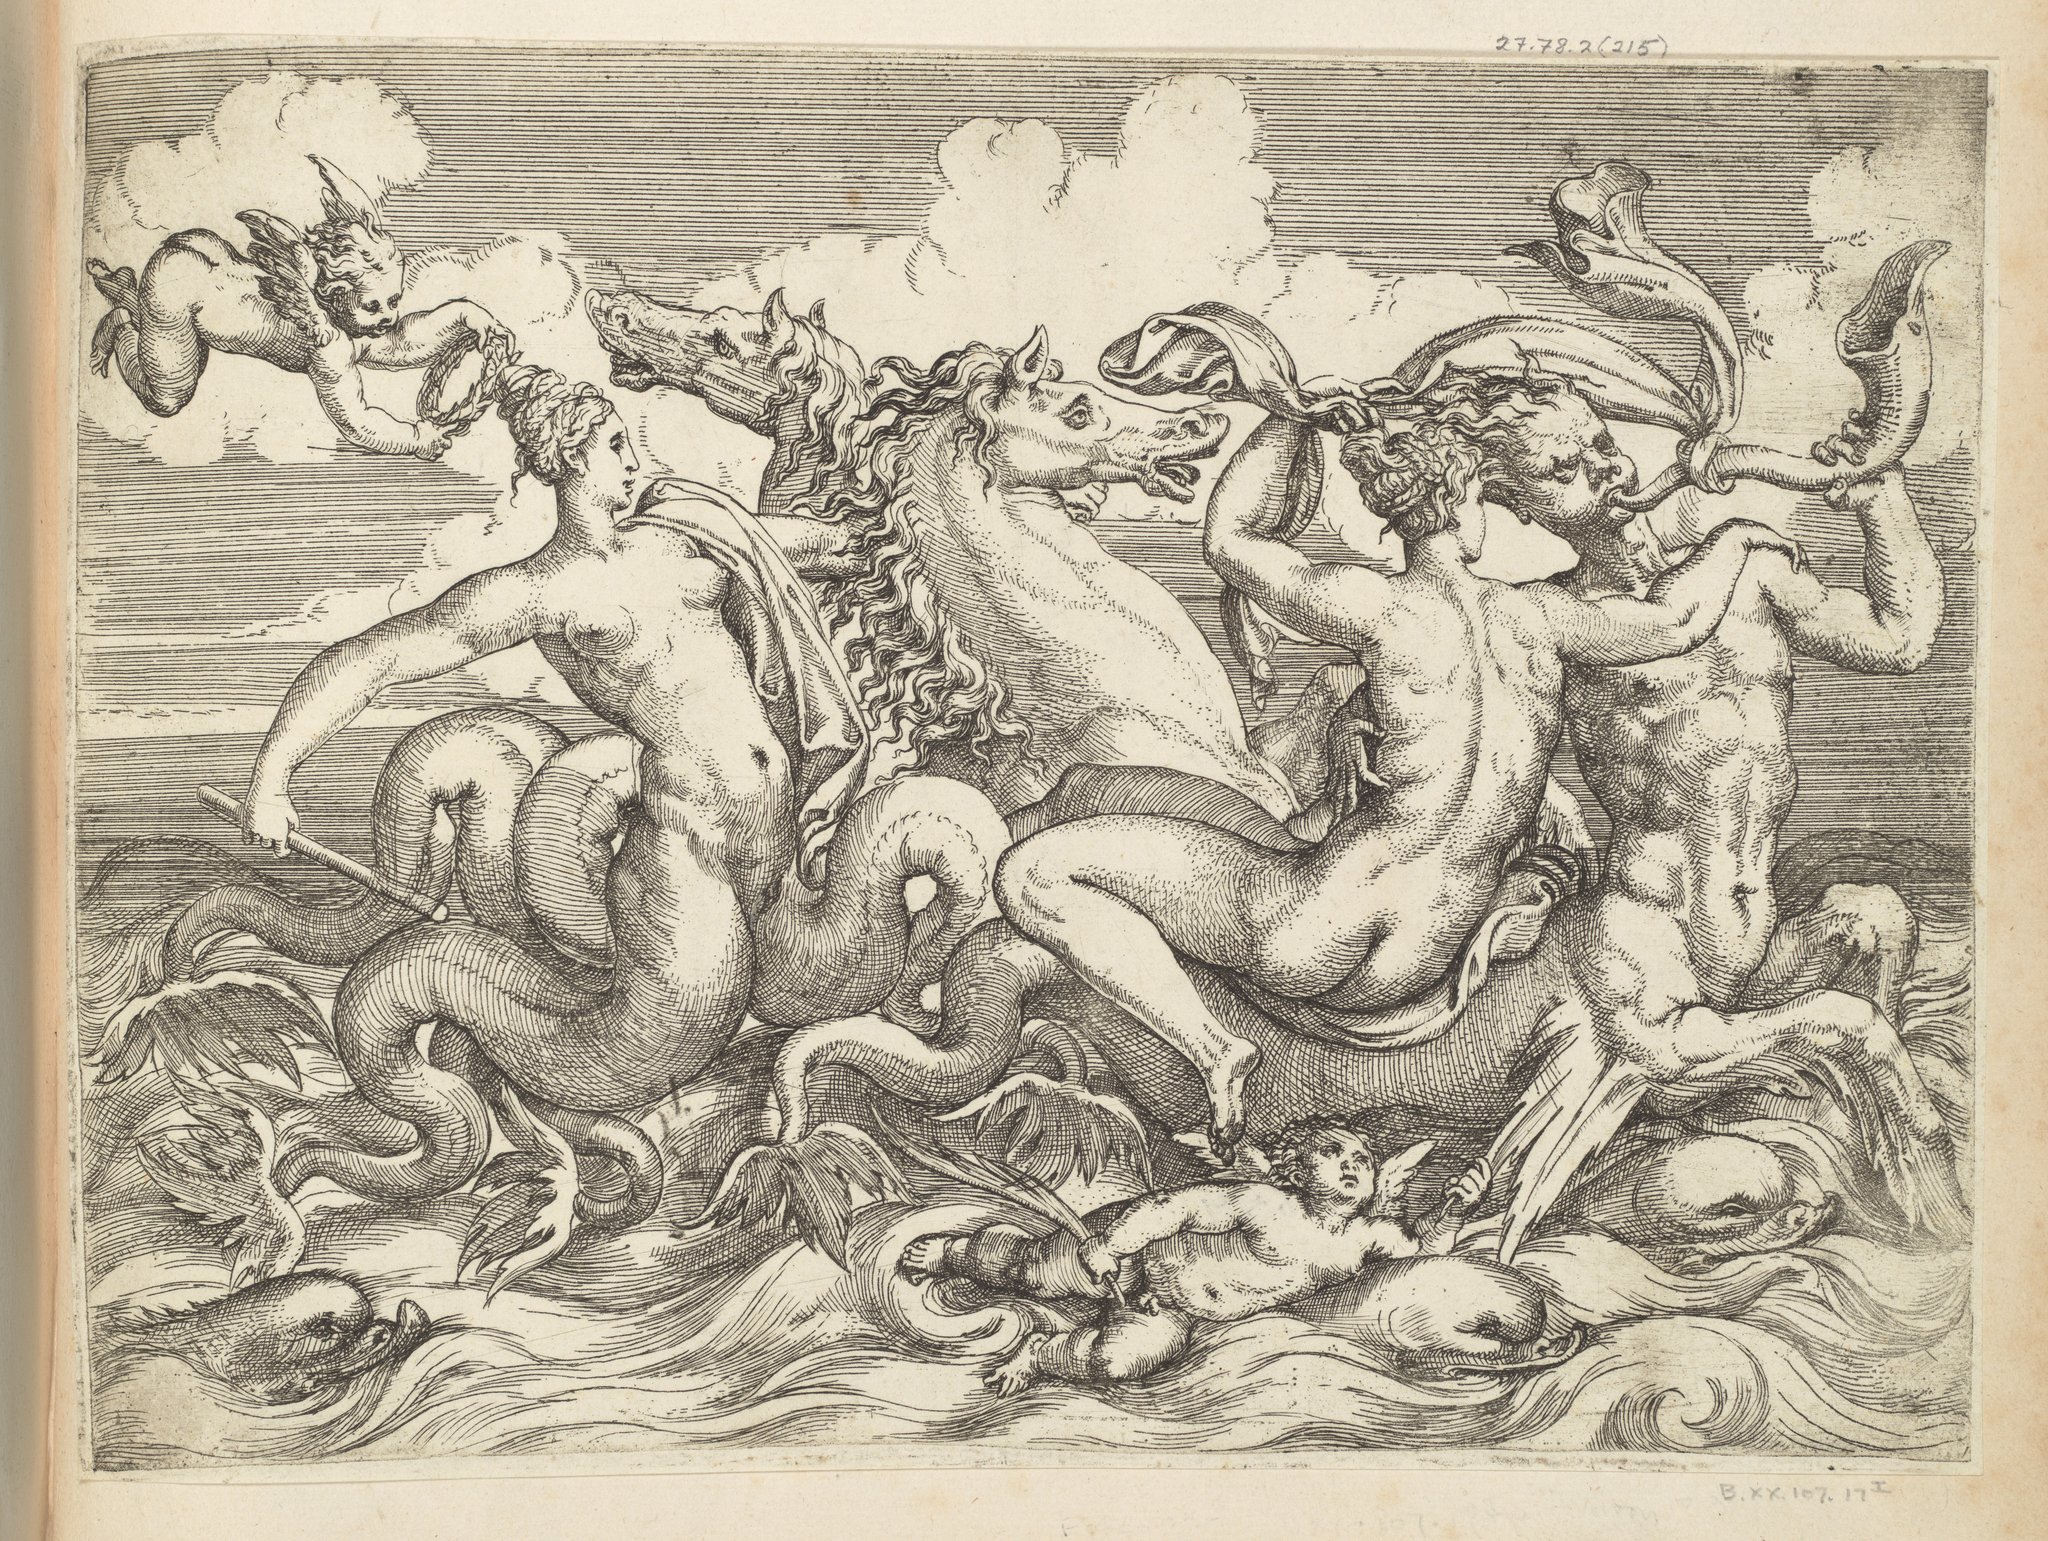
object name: print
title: A Nereid Riding a Sea Centaur Accompanied by Other Sea Creatures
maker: angiolo falconetto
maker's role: artist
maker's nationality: italian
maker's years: 1555-1567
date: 1540-1560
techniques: drypoint, etching